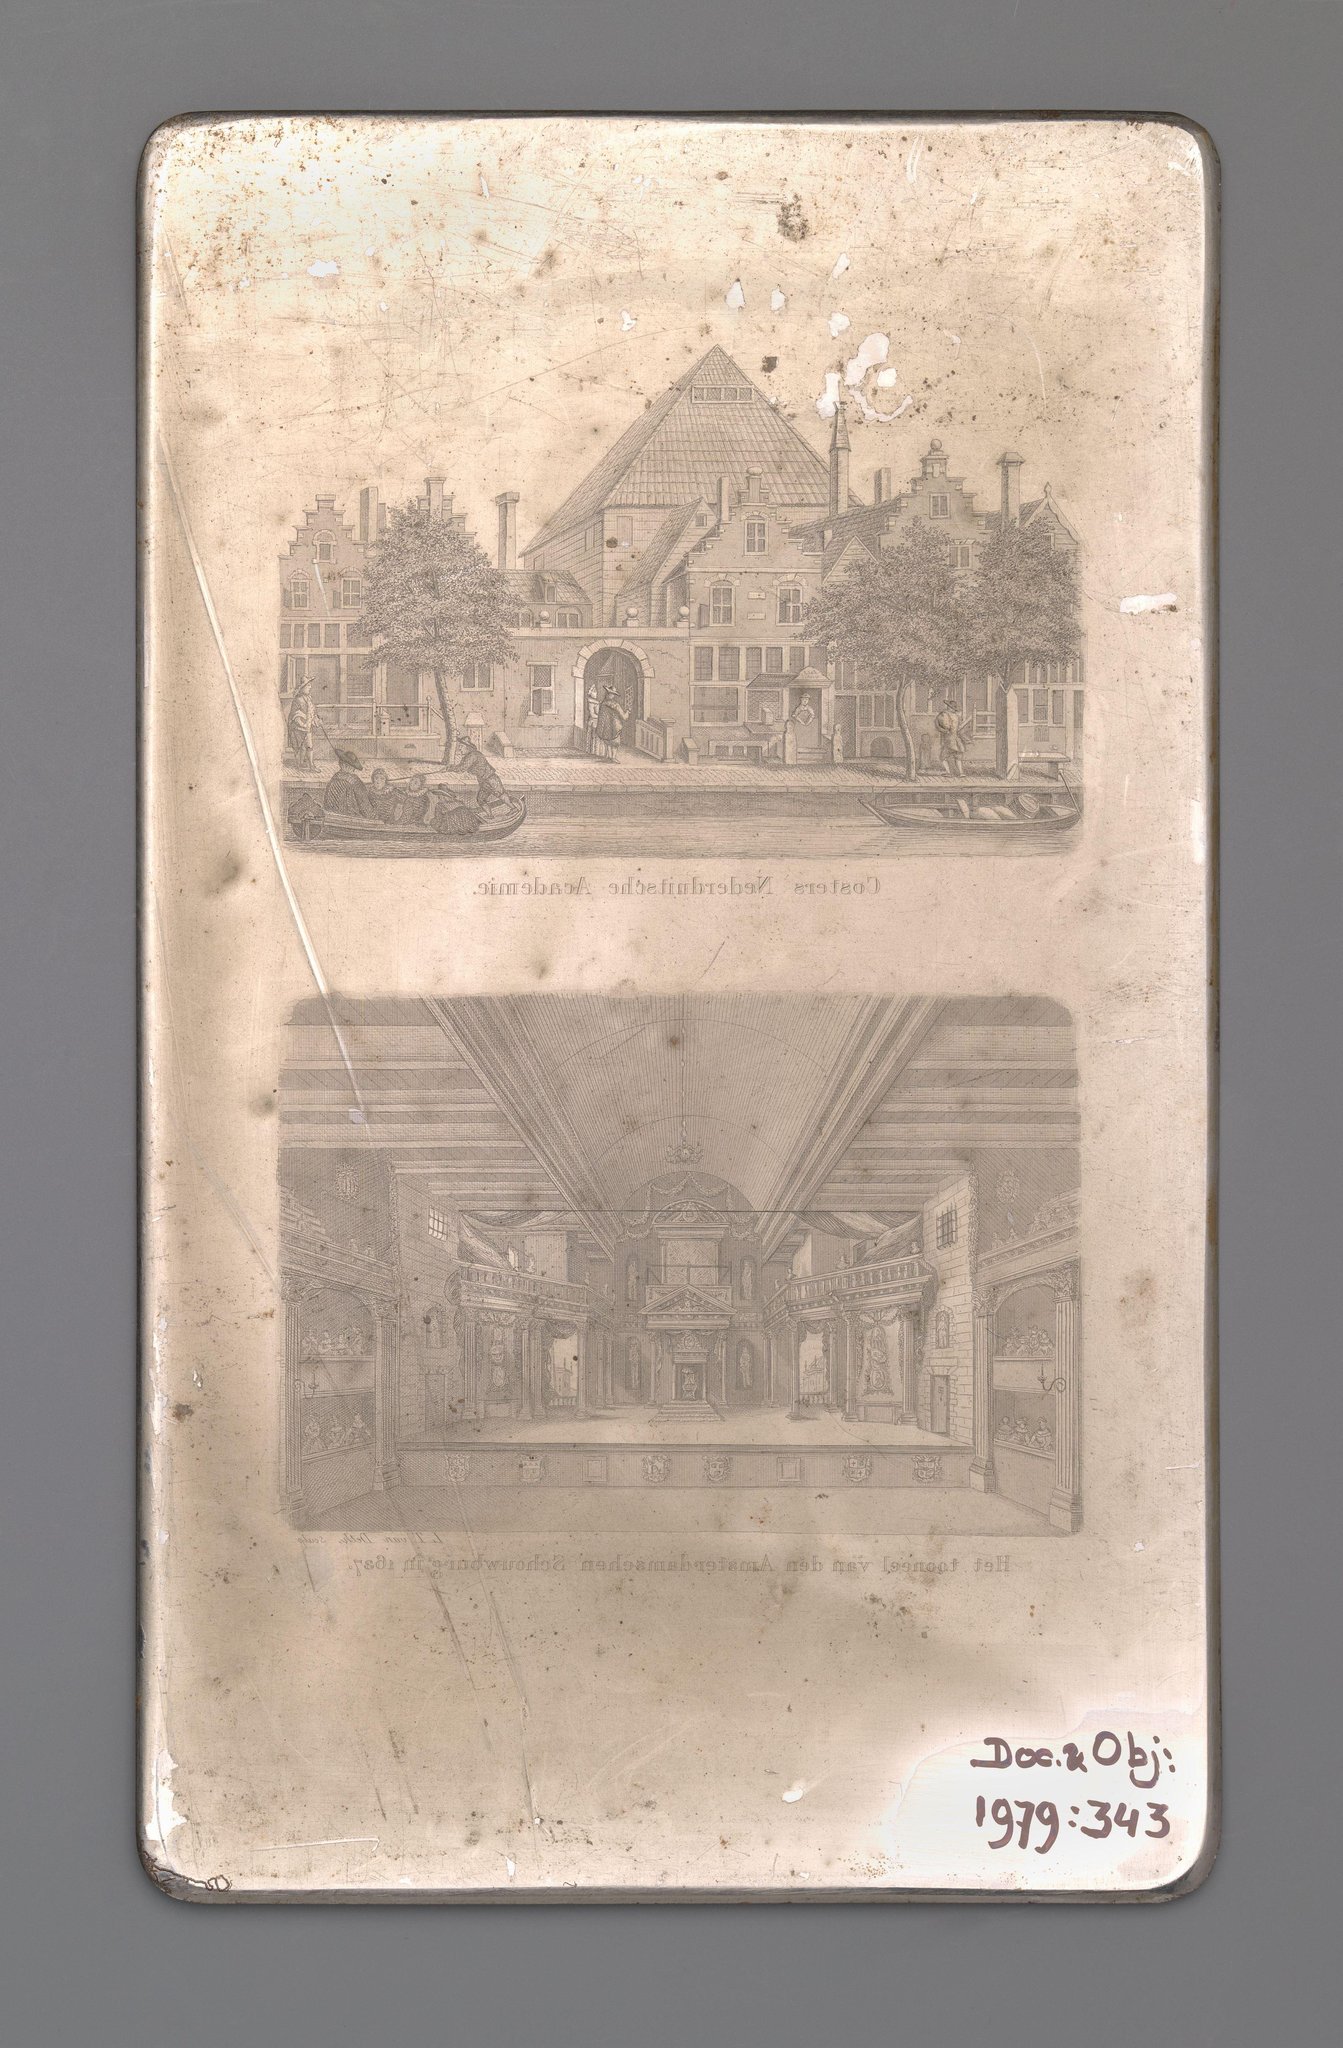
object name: staalplaat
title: 'Het toneel van den Amsterdamschen Schouwburg 1637' en 'Costers Nederduitsche [...]'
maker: lubertus teunis van deth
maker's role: draughtsman, print maker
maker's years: 1814-1875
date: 1814-1875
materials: steel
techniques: engraving